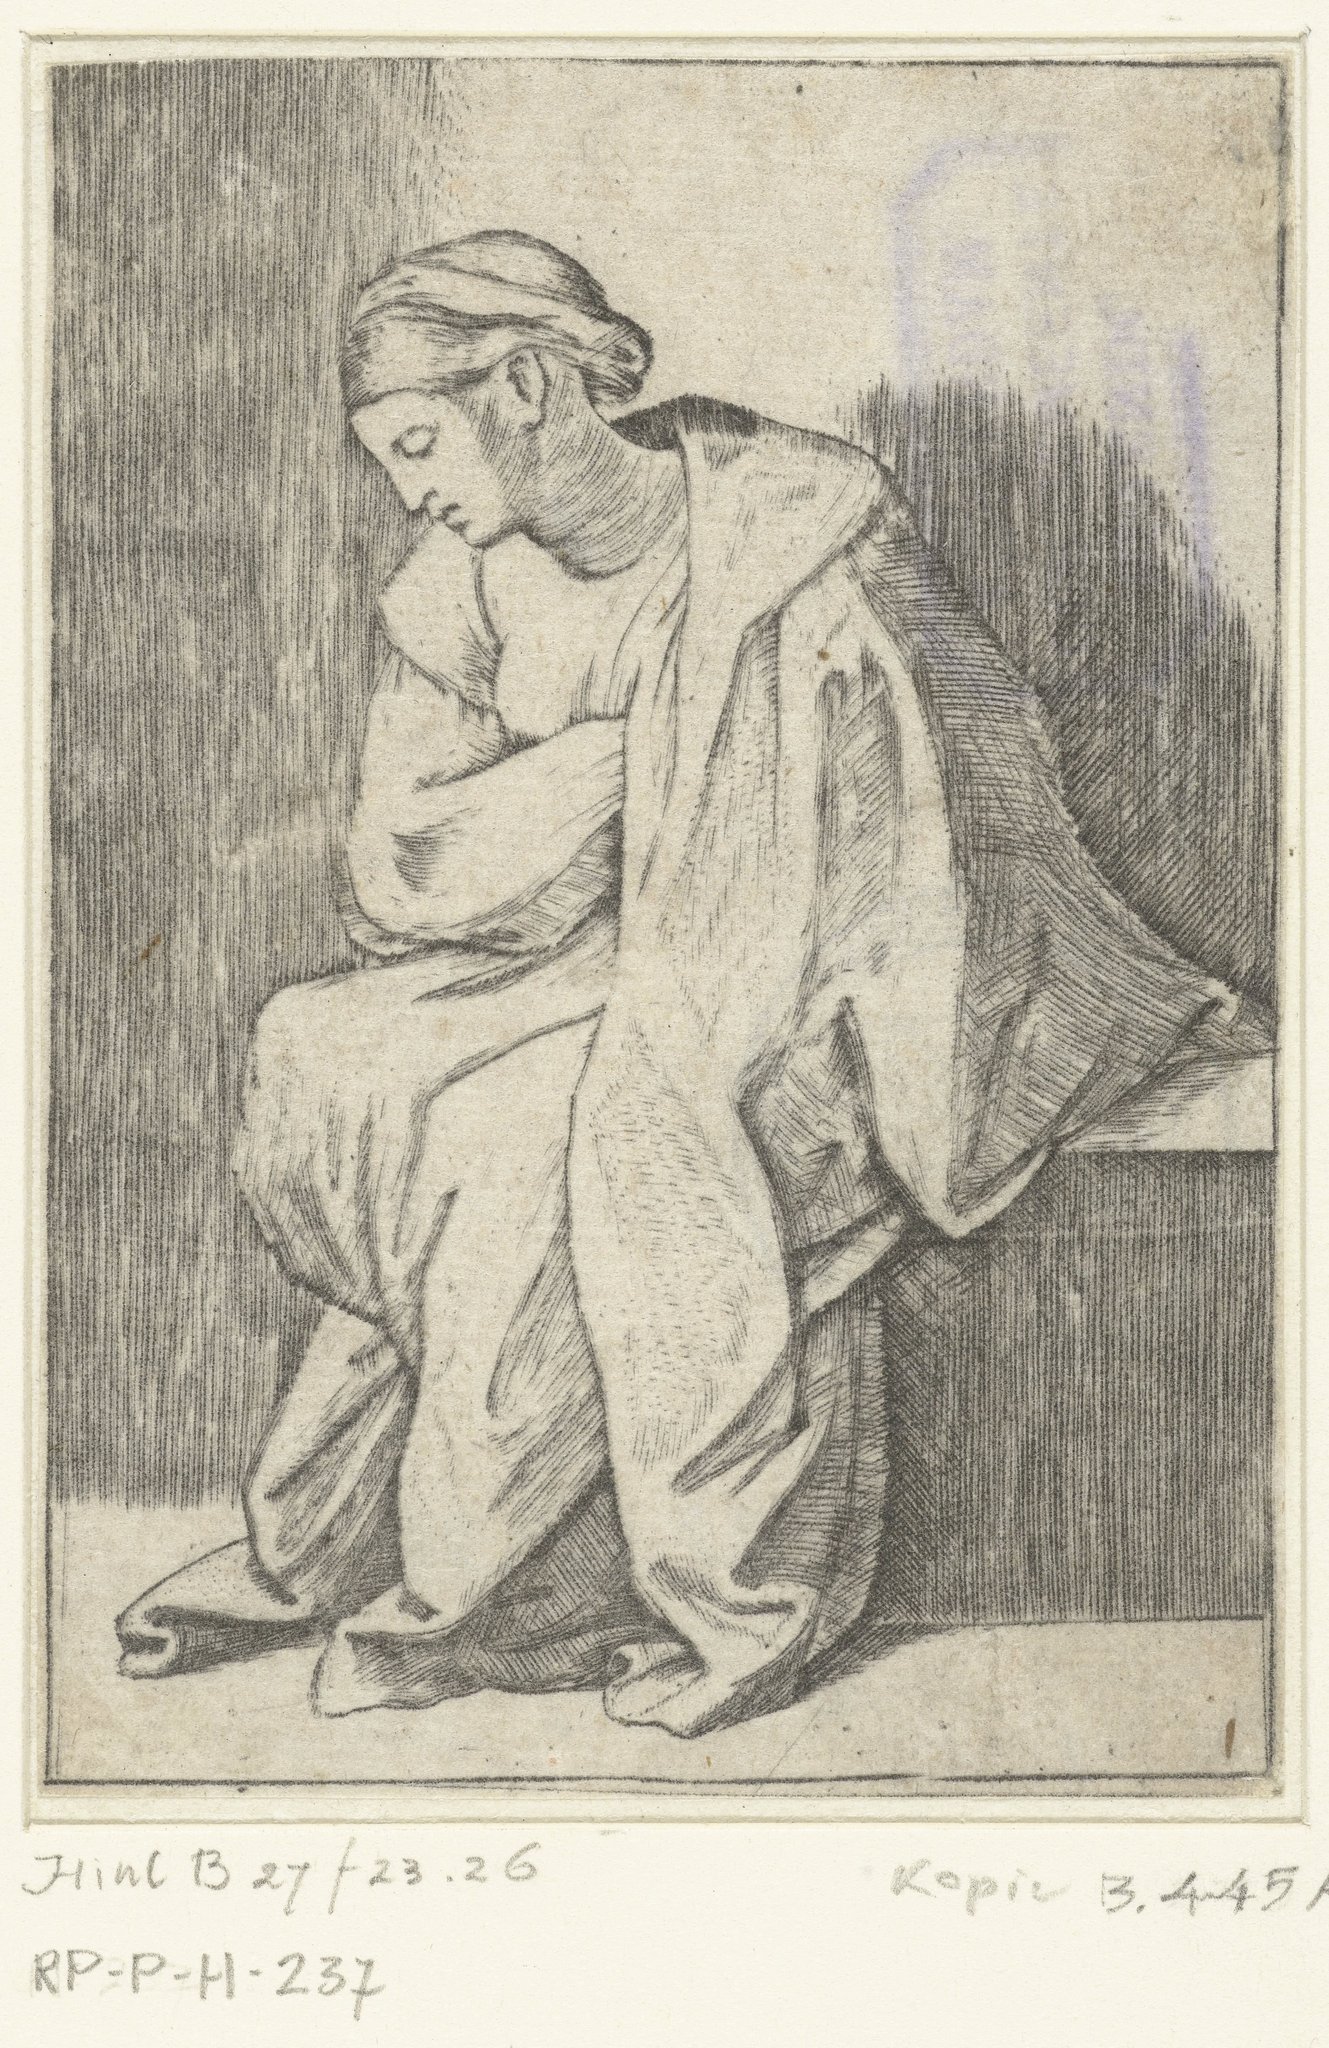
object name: print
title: Zittende vrouw in overpeinzing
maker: Anonymous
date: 1510-1575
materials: paper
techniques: engraving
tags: the (nude) human figure; 'corpo humano' (ripa) (+ thinking, meditating)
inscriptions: inscription: ‘B 27 f 23-26’, collector's mark: Lugt 11, collector's mark: Lugt 10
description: Kopie in spiegelbeeld naar prent van Marcantonio Raimondi. Raimondi baseerde zich op een ontwerp van Raphael.